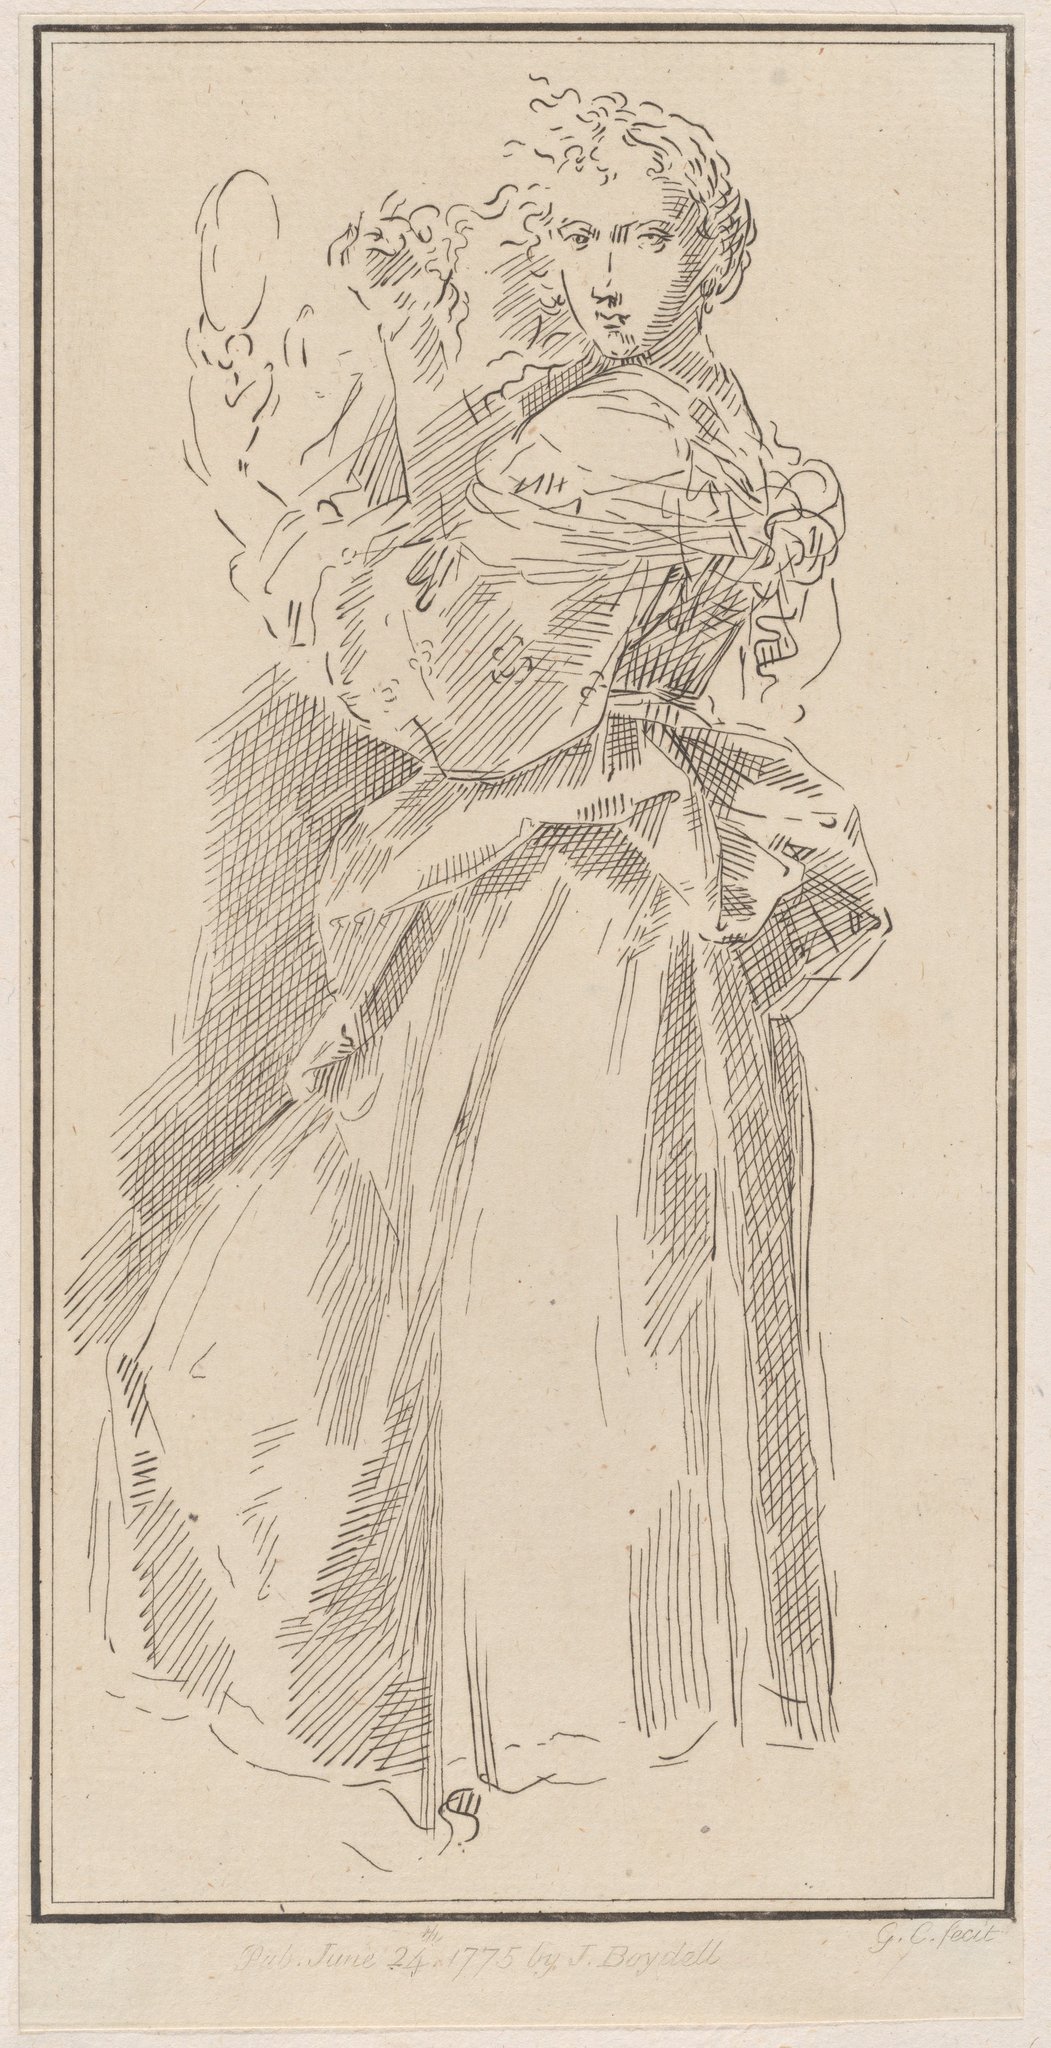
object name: print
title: Woman standing holding a mirror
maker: giuseppe canale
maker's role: artist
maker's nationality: italian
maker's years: 1725-1802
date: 1775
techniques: etching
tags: women